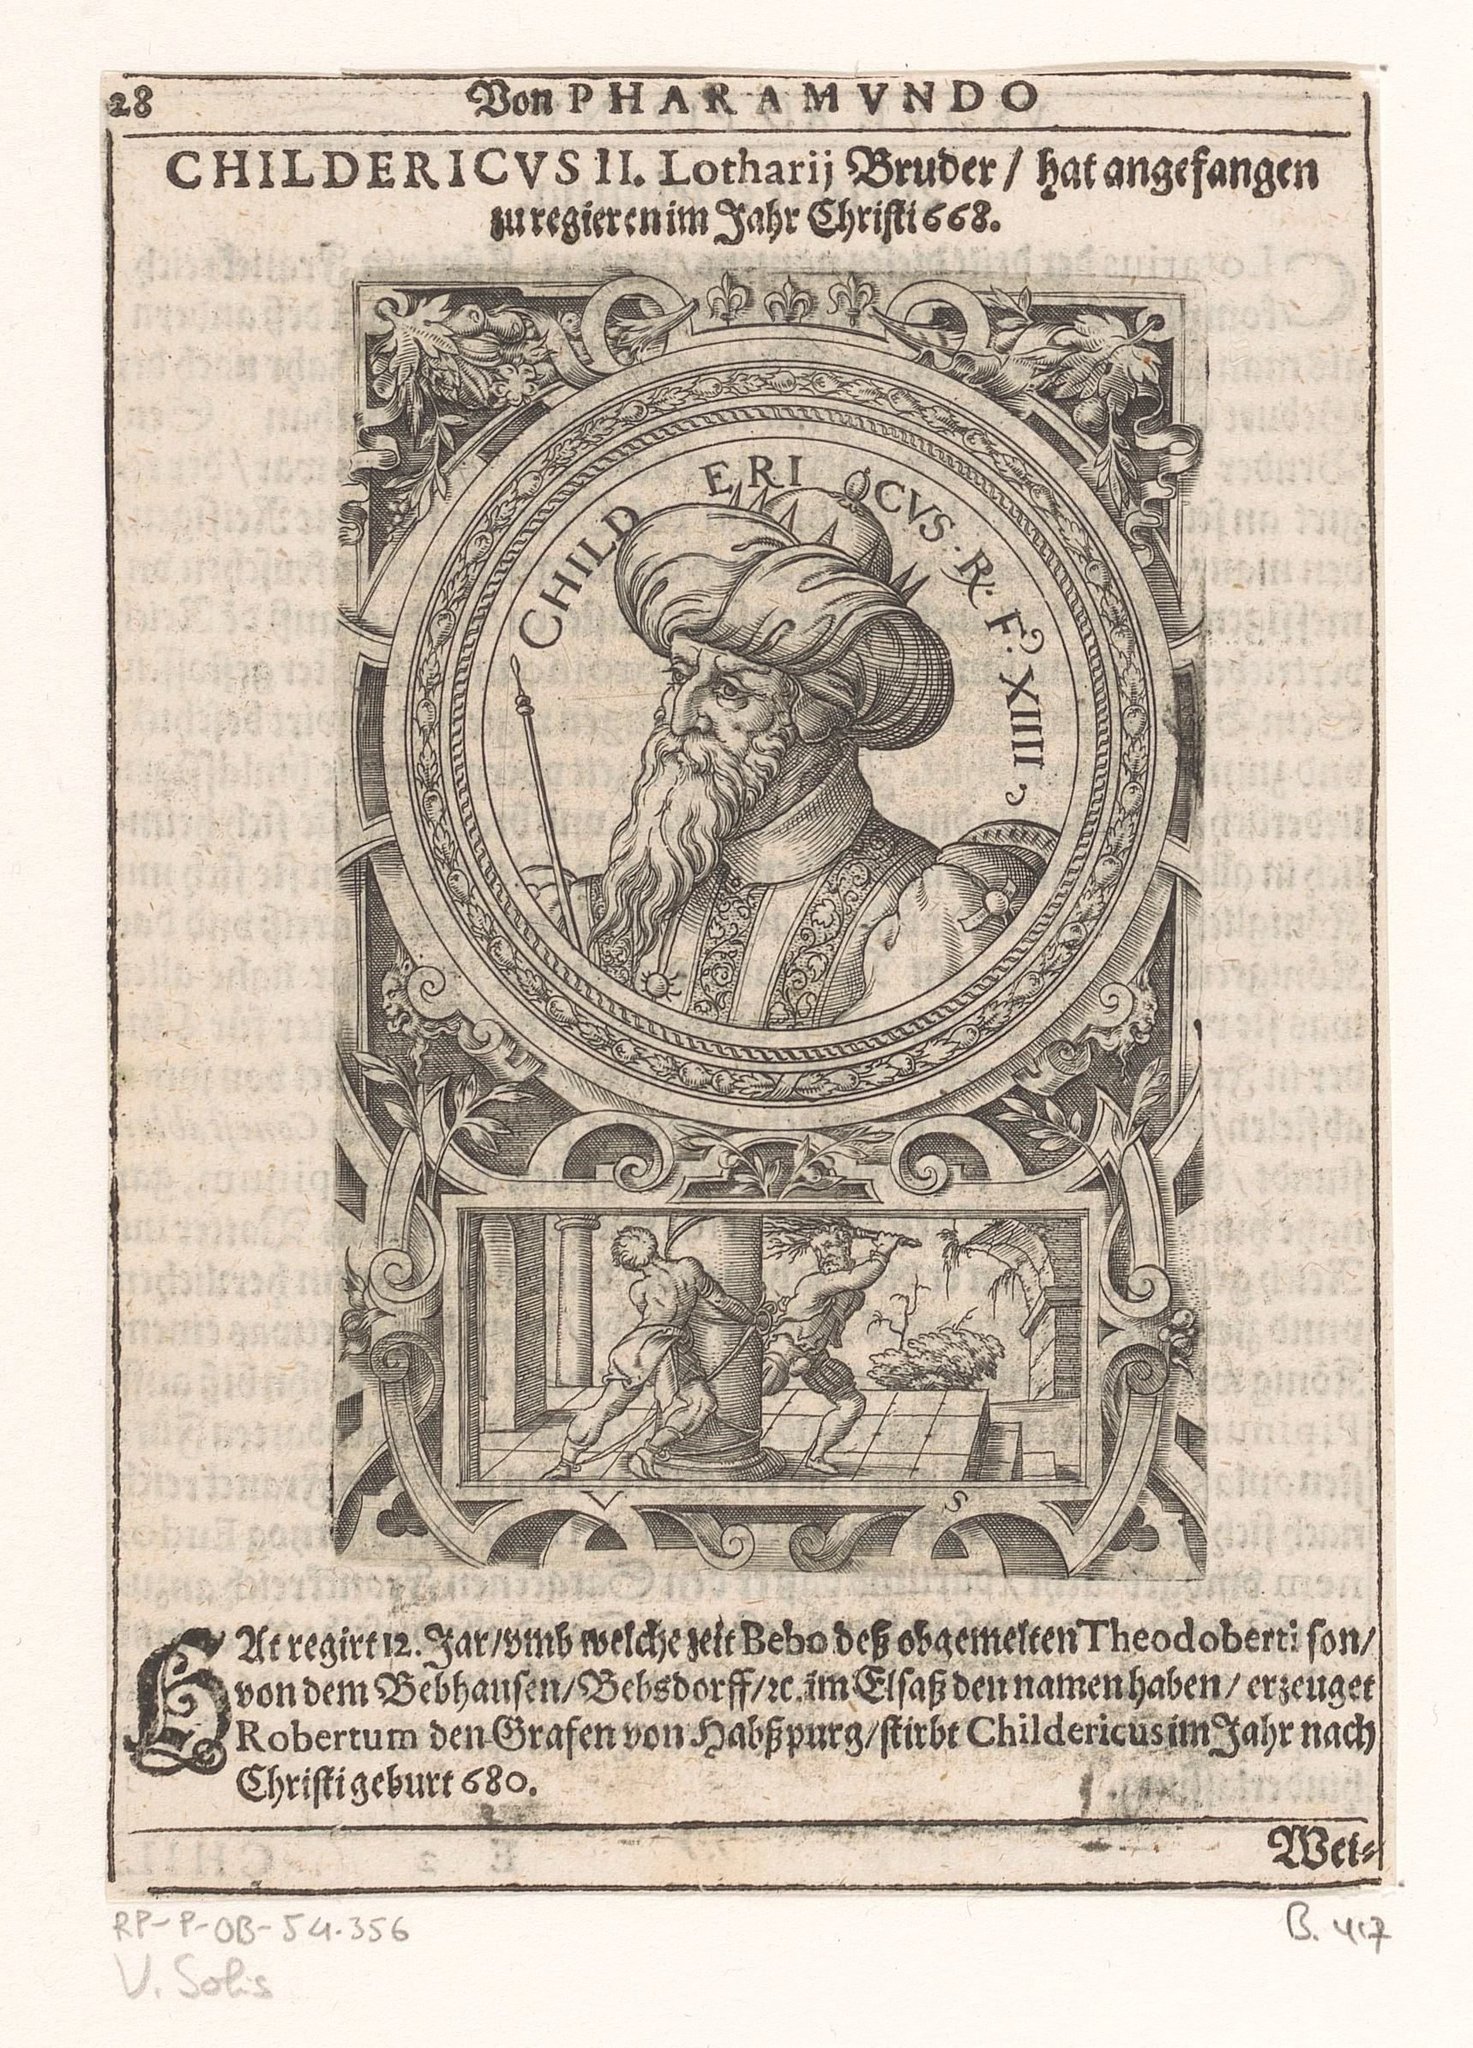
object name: print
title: Portret van Childerik II, koning van Austrasië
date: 1598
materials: paper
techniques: engraving, etching, intaglio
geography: nuremberg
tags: scrollwork, strapwork ~ ornament, historical persons, ruler, sovereign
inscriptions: number, collector's mark: Lugt 2228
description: Prent afkomstig uit de publicatie: Michael Eizinger. Könige in Frankreich. Keulen: Johann Bussemacher, 1598, p. 28. De publicatie bevat prenten van Jost Amman en Virgil Solis.